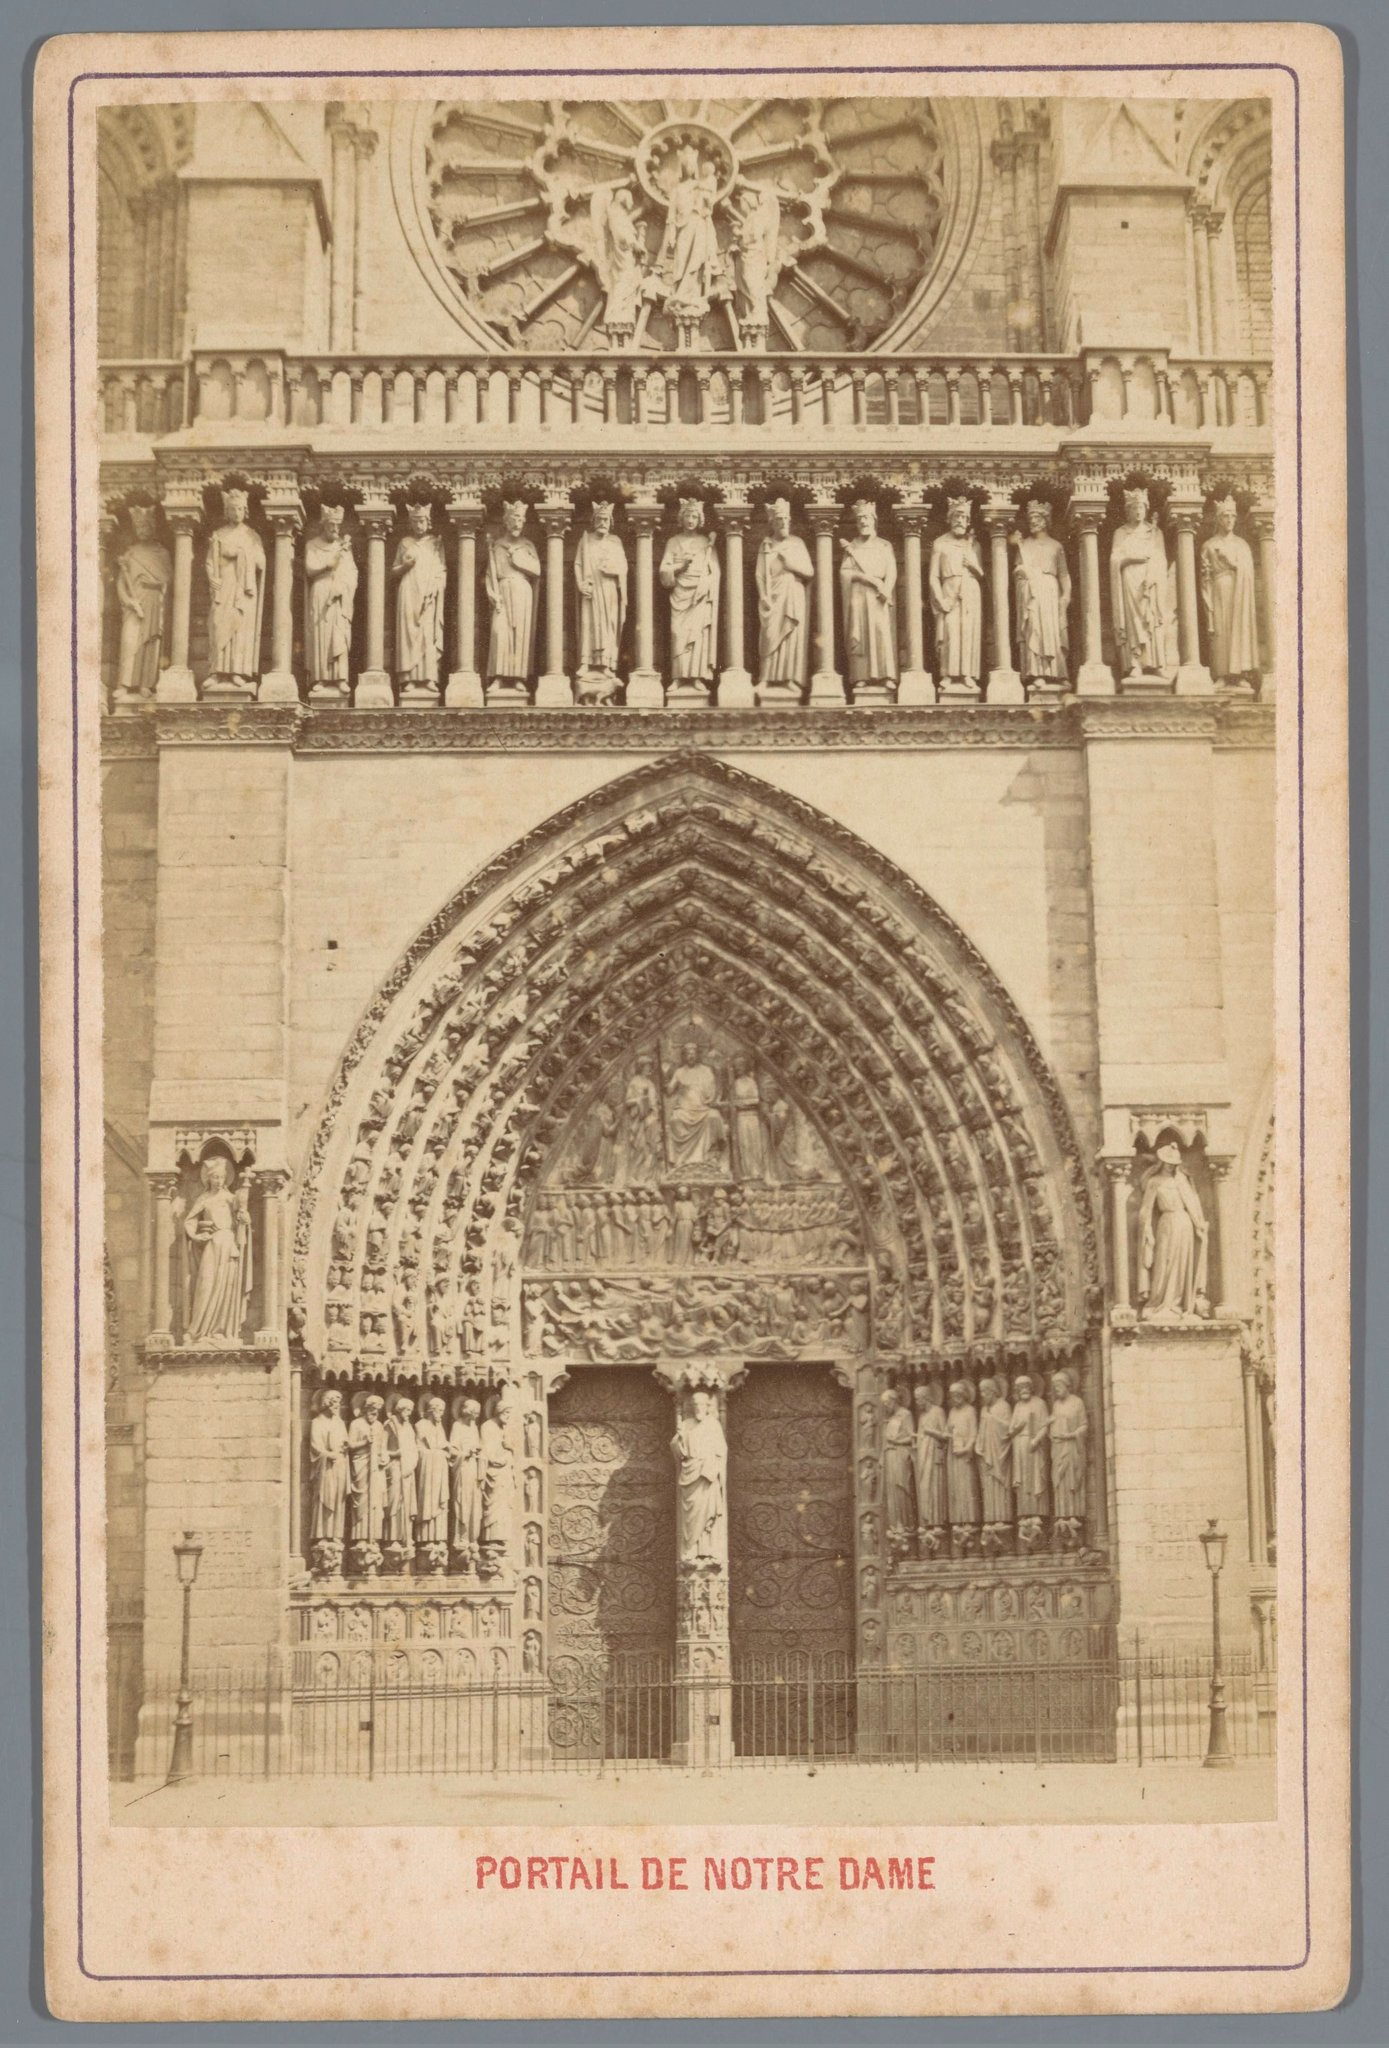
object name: cabinet photograph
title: Portail de Notre Dame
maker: Anonymous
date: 1865-1875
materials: cardboard, photographic support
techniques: albumen print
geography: paris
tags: parts of church exterior and annexes: portal